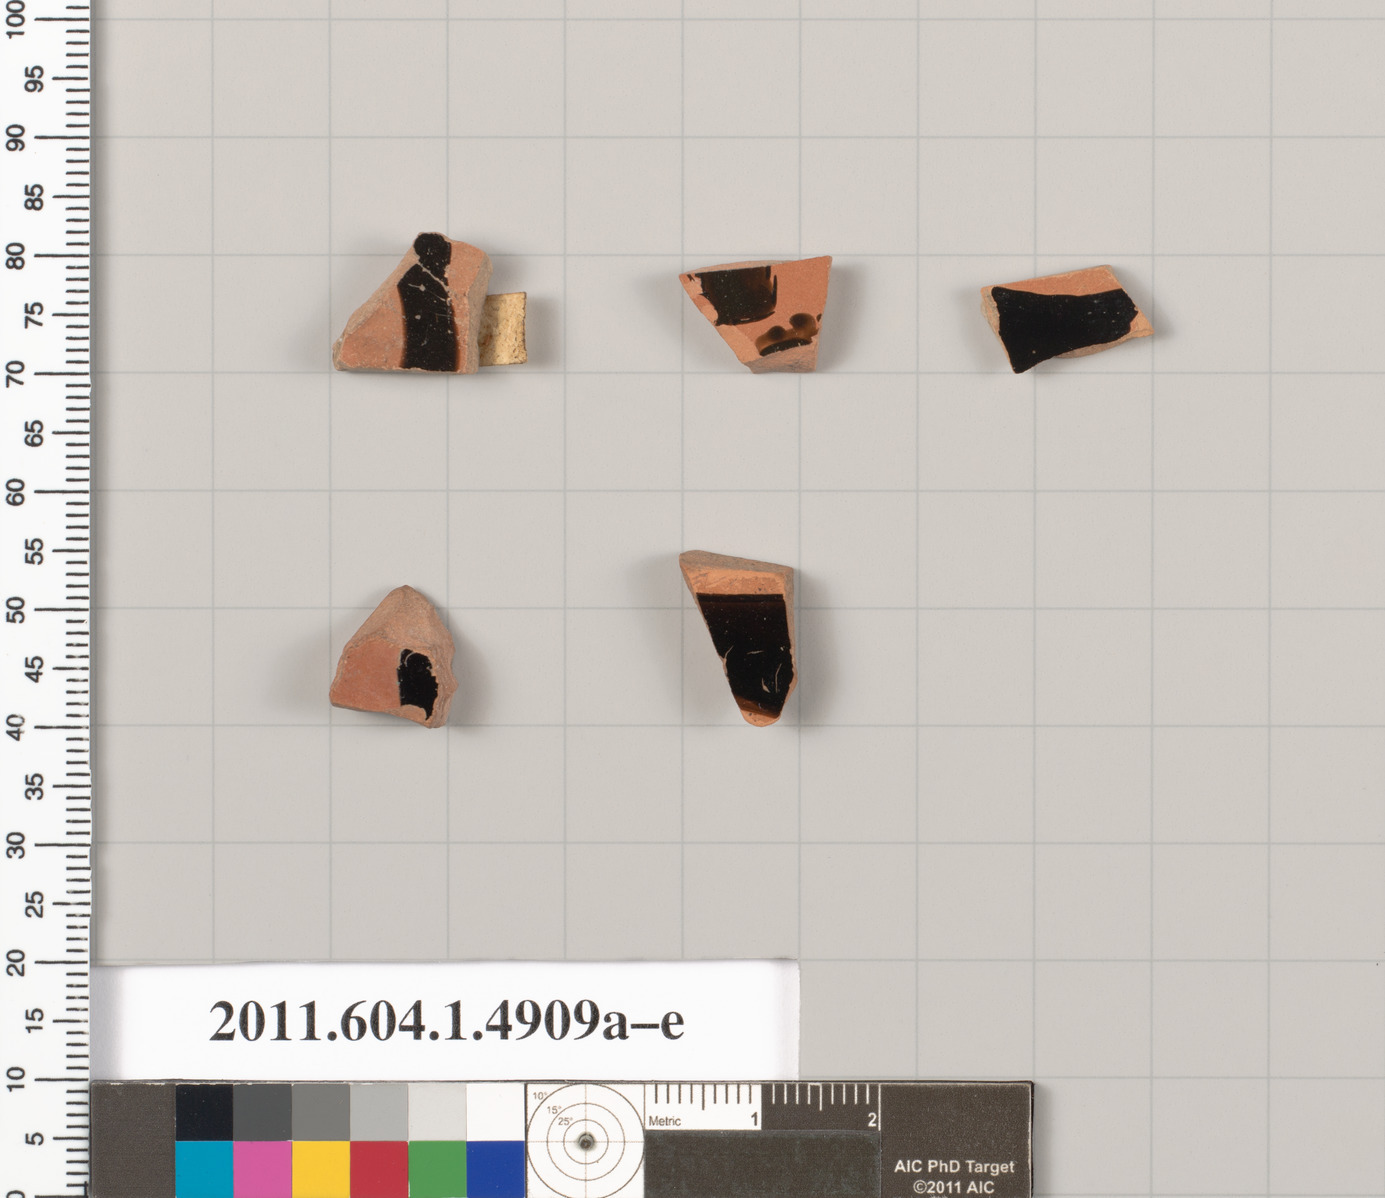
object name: kylix fragment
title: Terracotta fragments of kylikes (drinking cups)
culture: greek, attic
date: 600-401 BCE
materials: terracotta